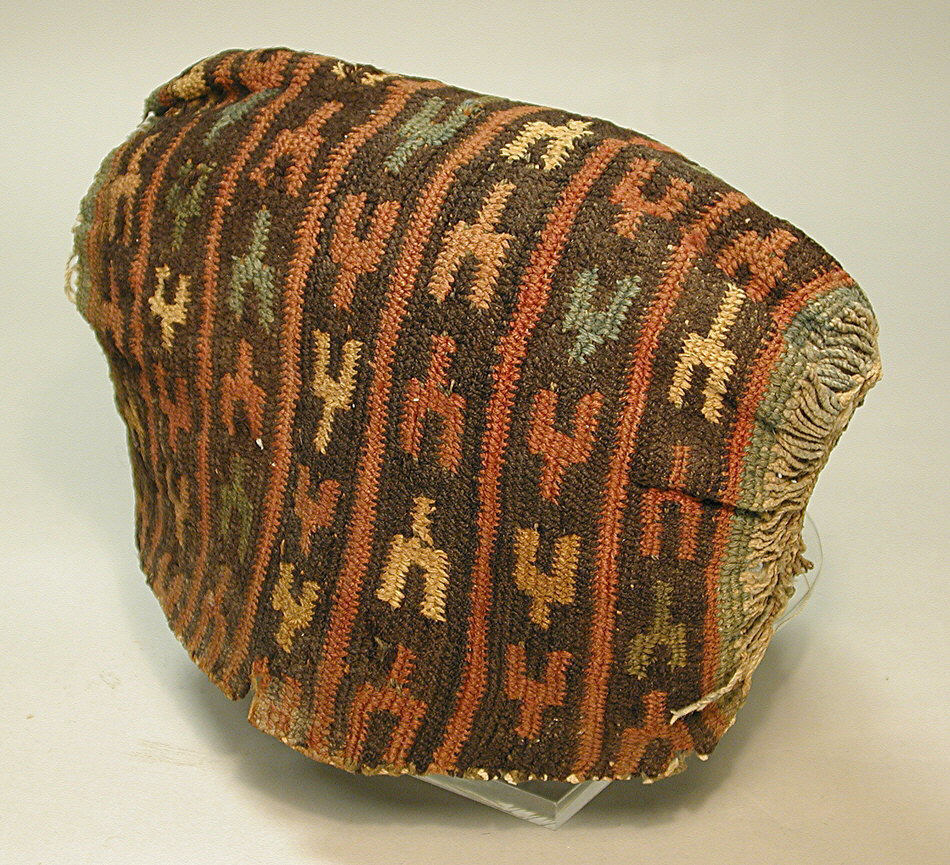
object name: hat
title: Cap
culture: peruvian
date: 1301-1533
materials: animal fiber, cotton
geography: peru